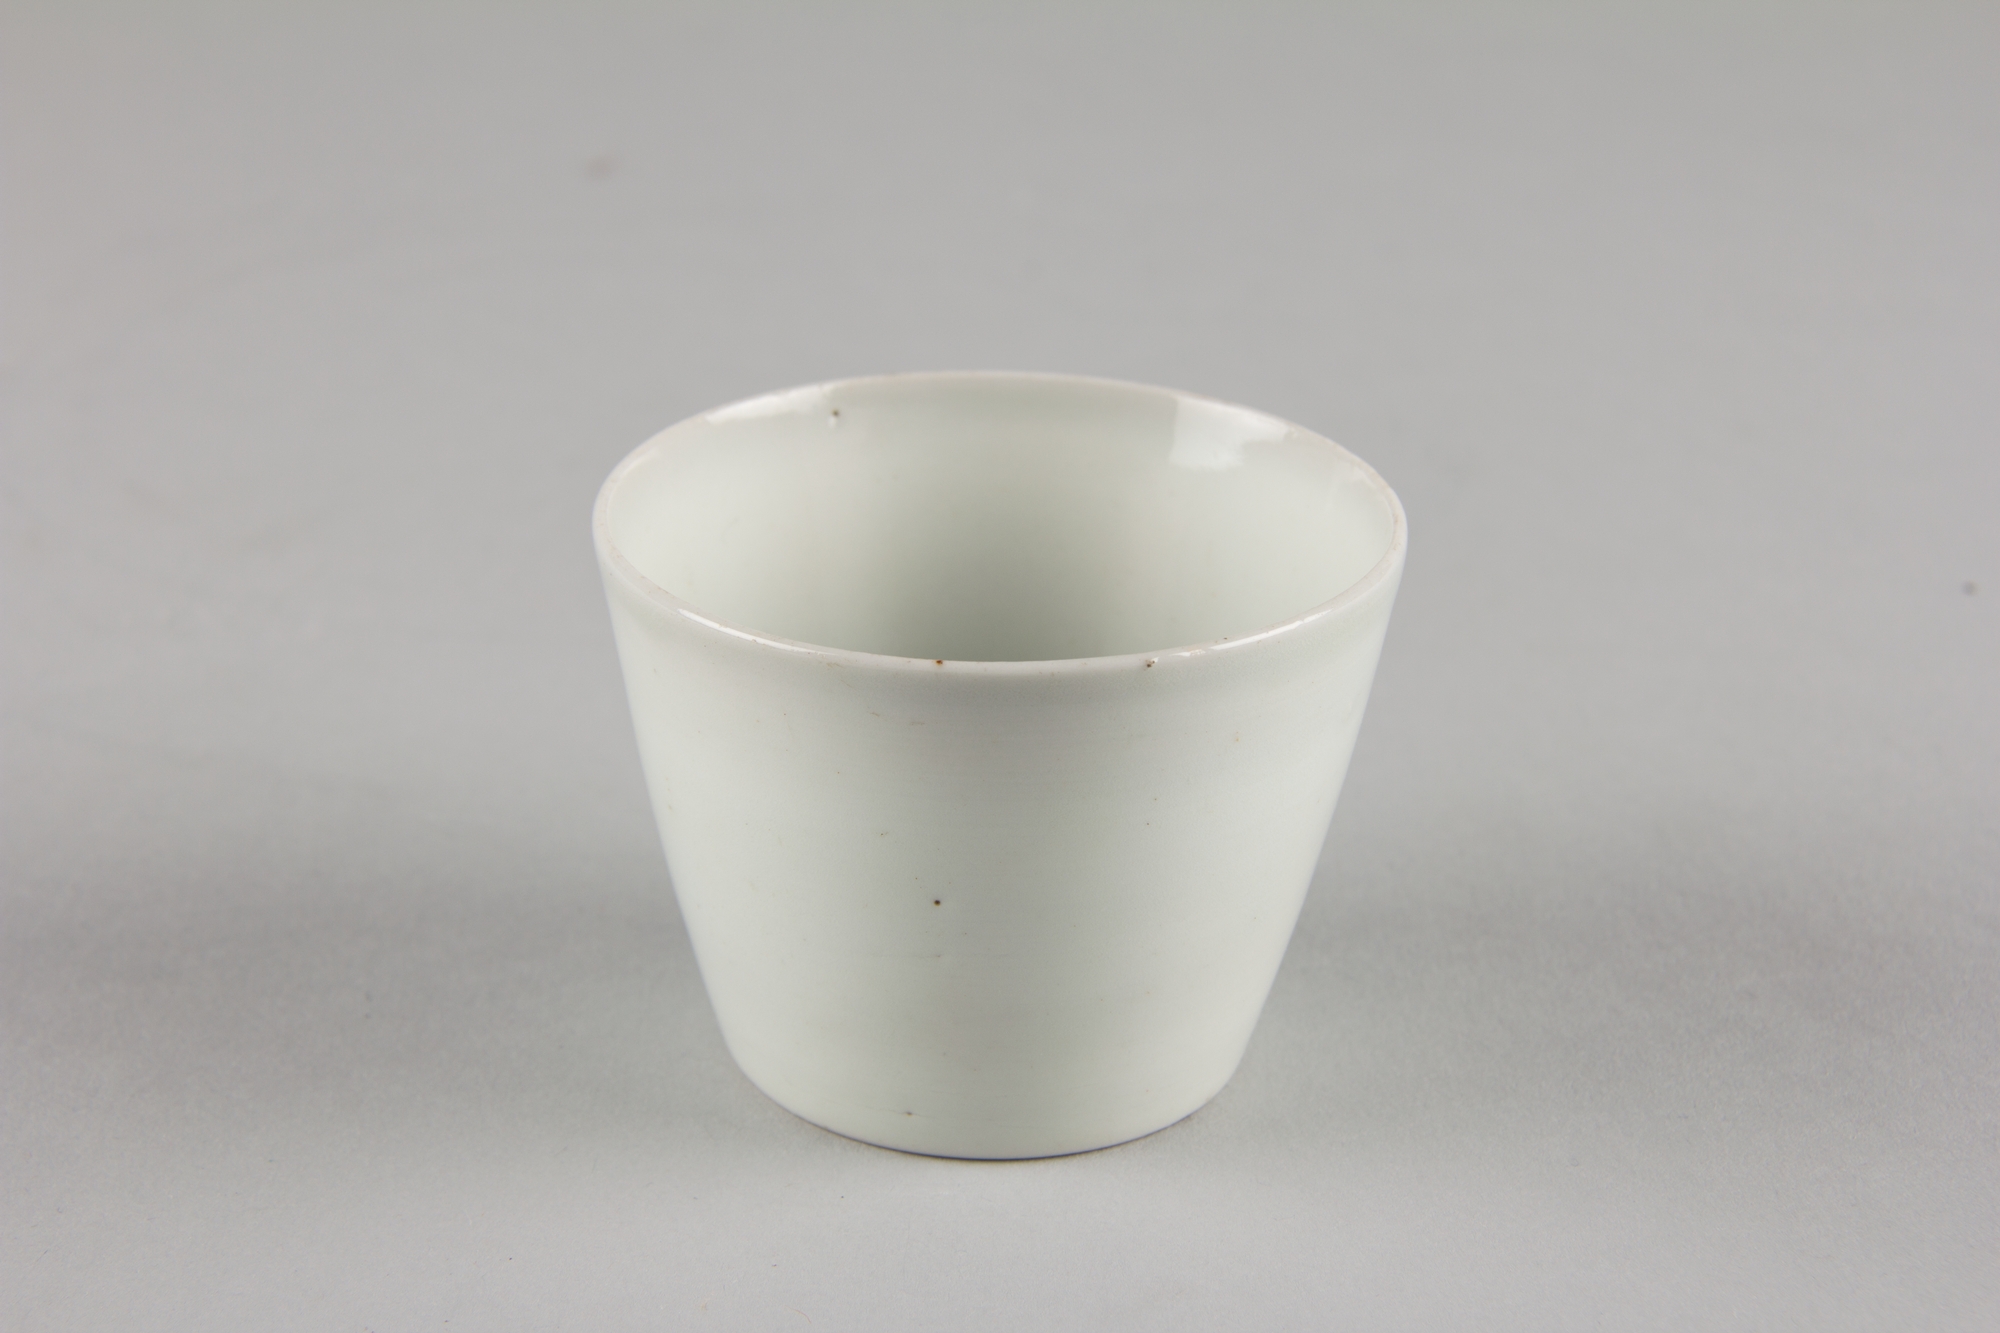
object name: soba cup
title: One from a Set of Five Soba Cups with Chrysanthemum Design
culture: japanese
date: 1615-1868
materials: porcelain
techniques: underglaze